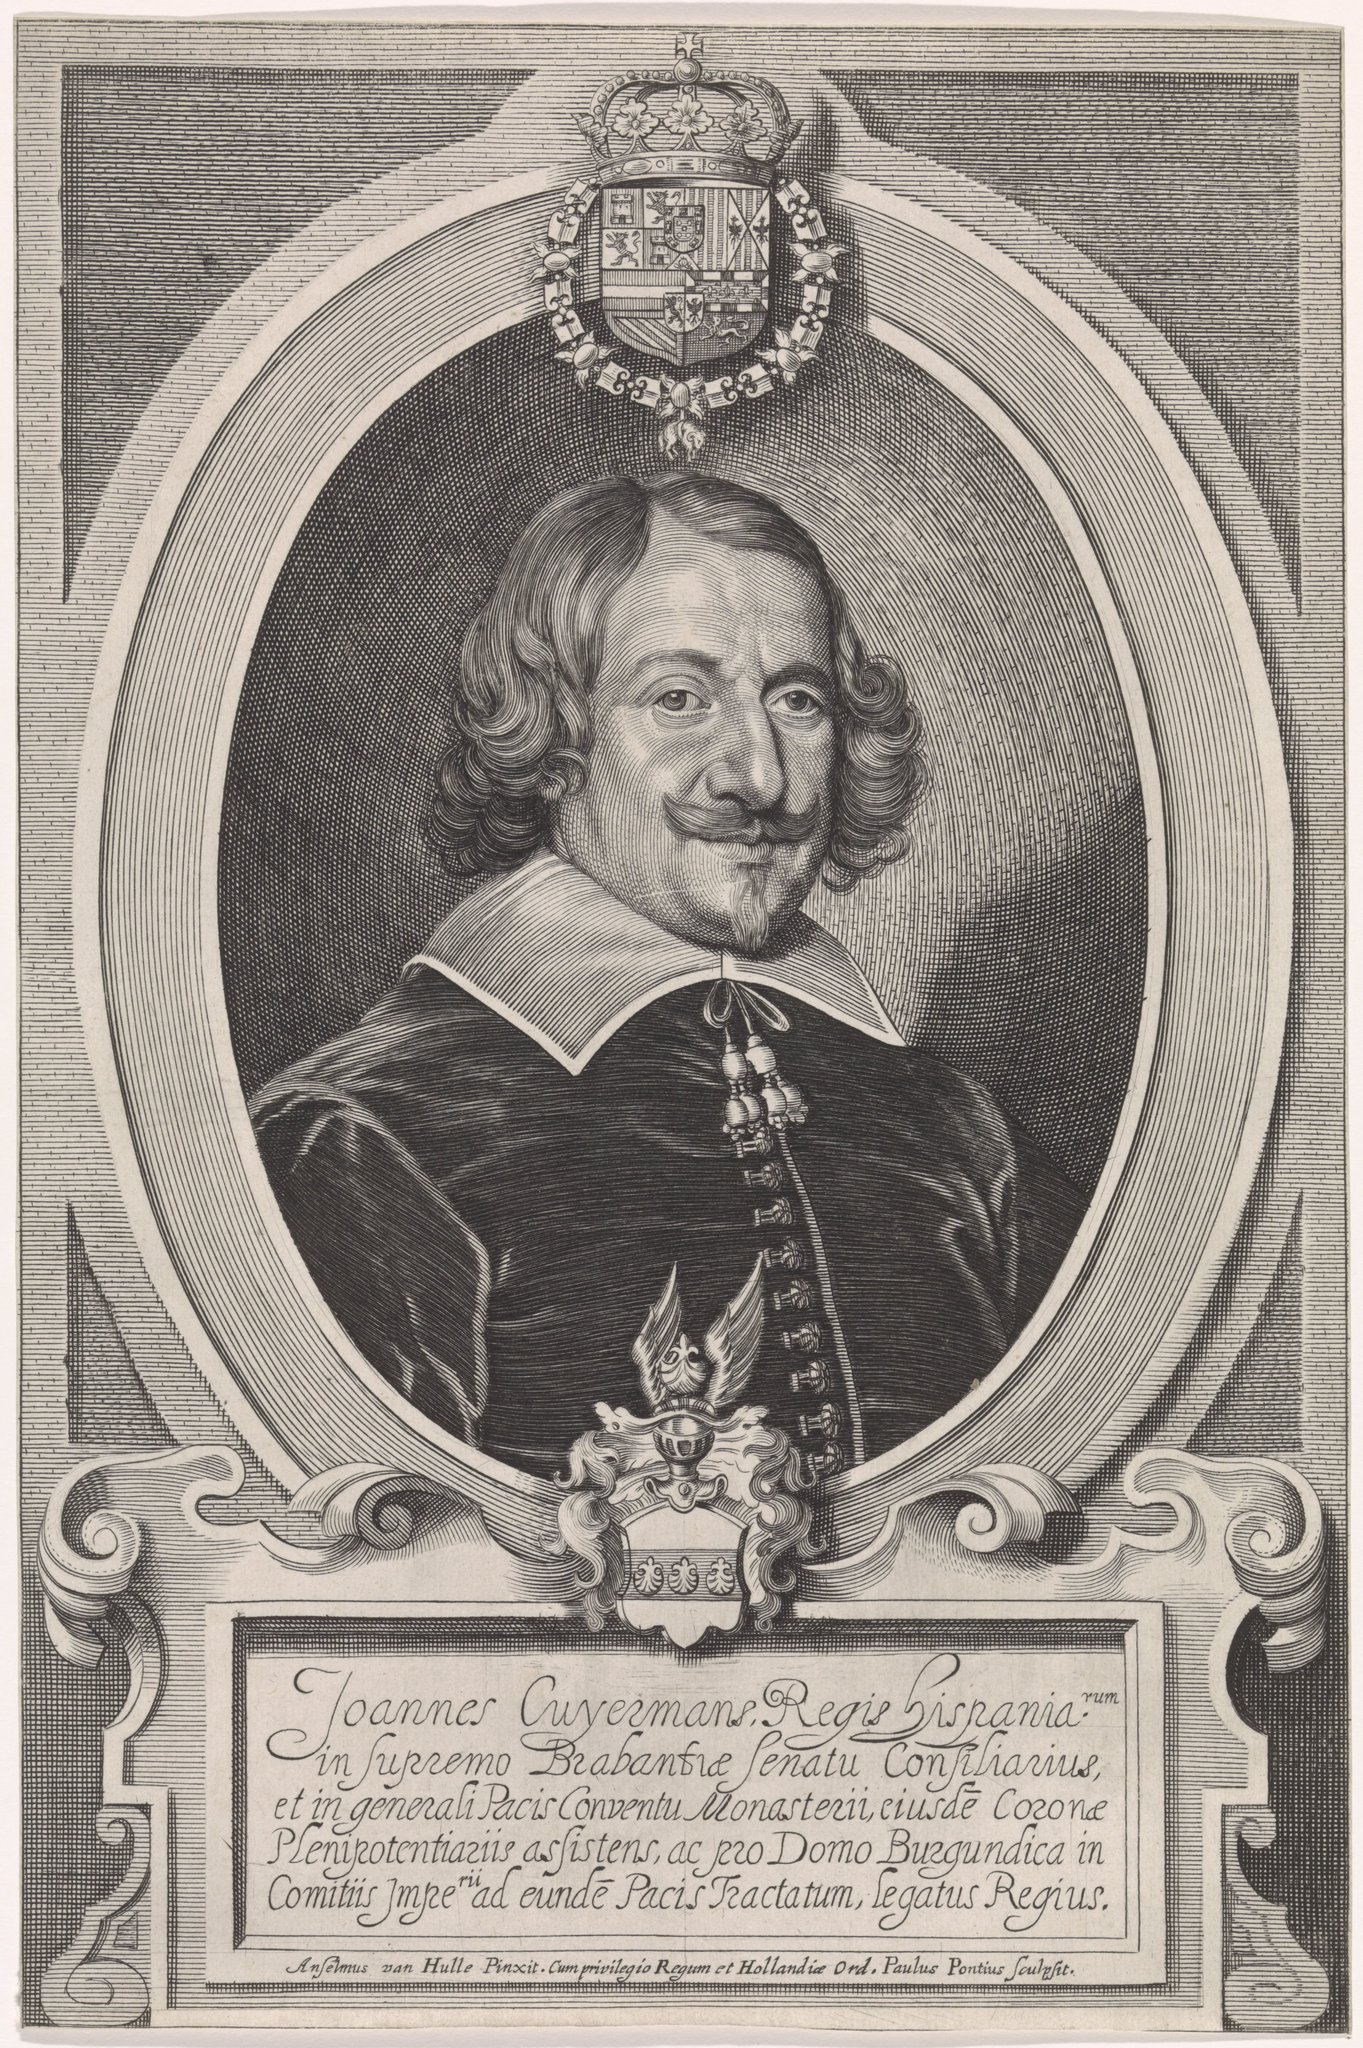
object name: print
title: Portret van Johannes Cuyermans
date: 1648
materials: paper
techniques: engraving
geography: antwerp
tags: knighthood order of the golden fleece, armorial bearing, heraldry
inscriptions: collector's mark: Lugt 2228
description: Prent ook opgenomen in: Pacis antesignani, sive icones legatorum ad pacem universalem constituendam (...). Antwerpen: Daniel Middelerius, 1648.